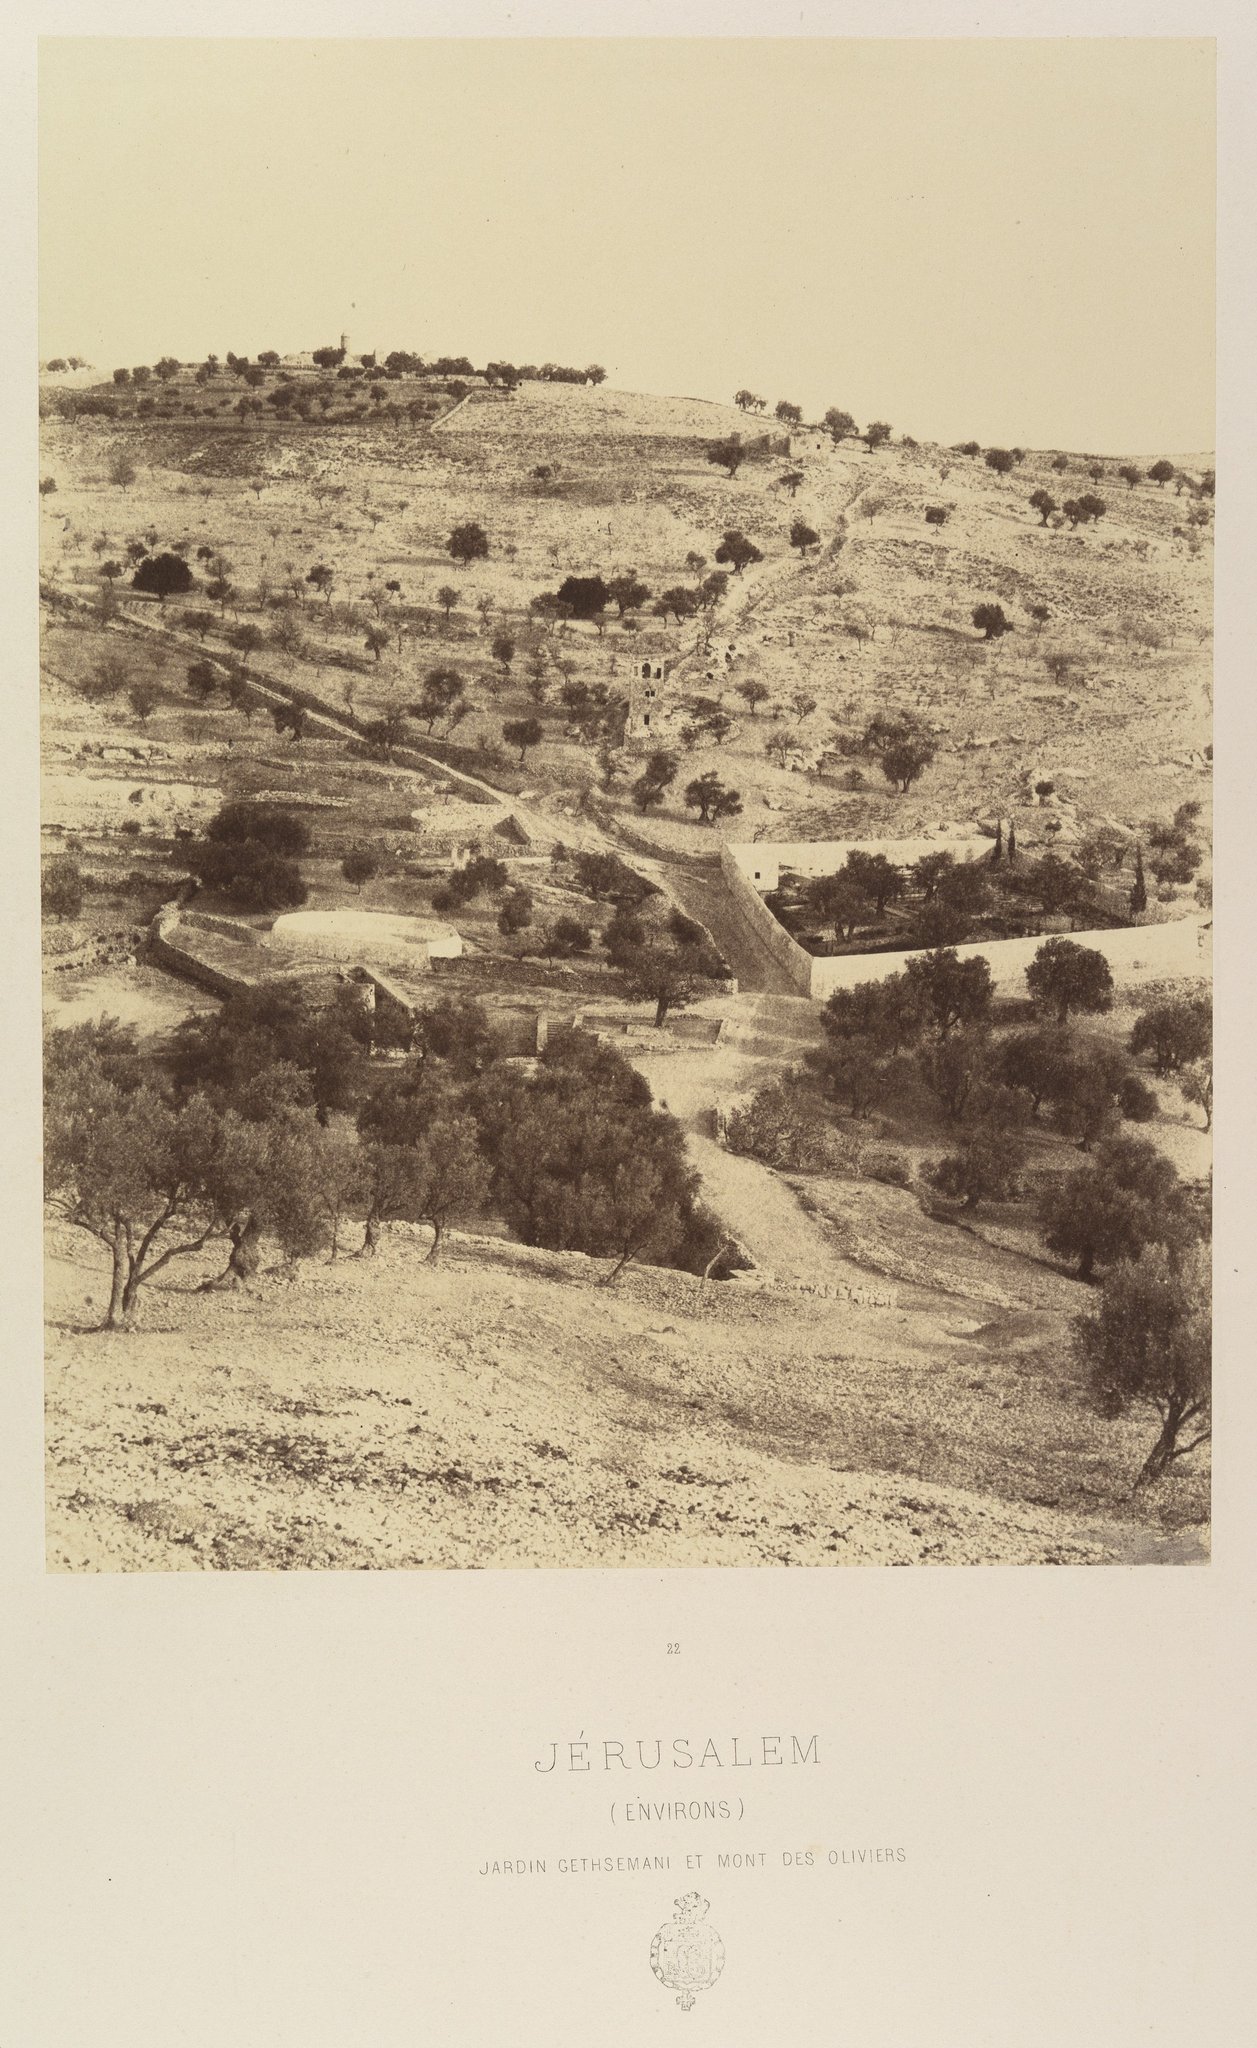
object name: photograph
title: Jérusalem. (Environs) Jardin Gethsemani et Mont des Oliviers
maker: louis de clercq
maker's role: artist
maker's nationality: french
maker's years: 1837-1901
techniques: albumen silver print, paper negative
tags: gardens,landscapes,olive trees